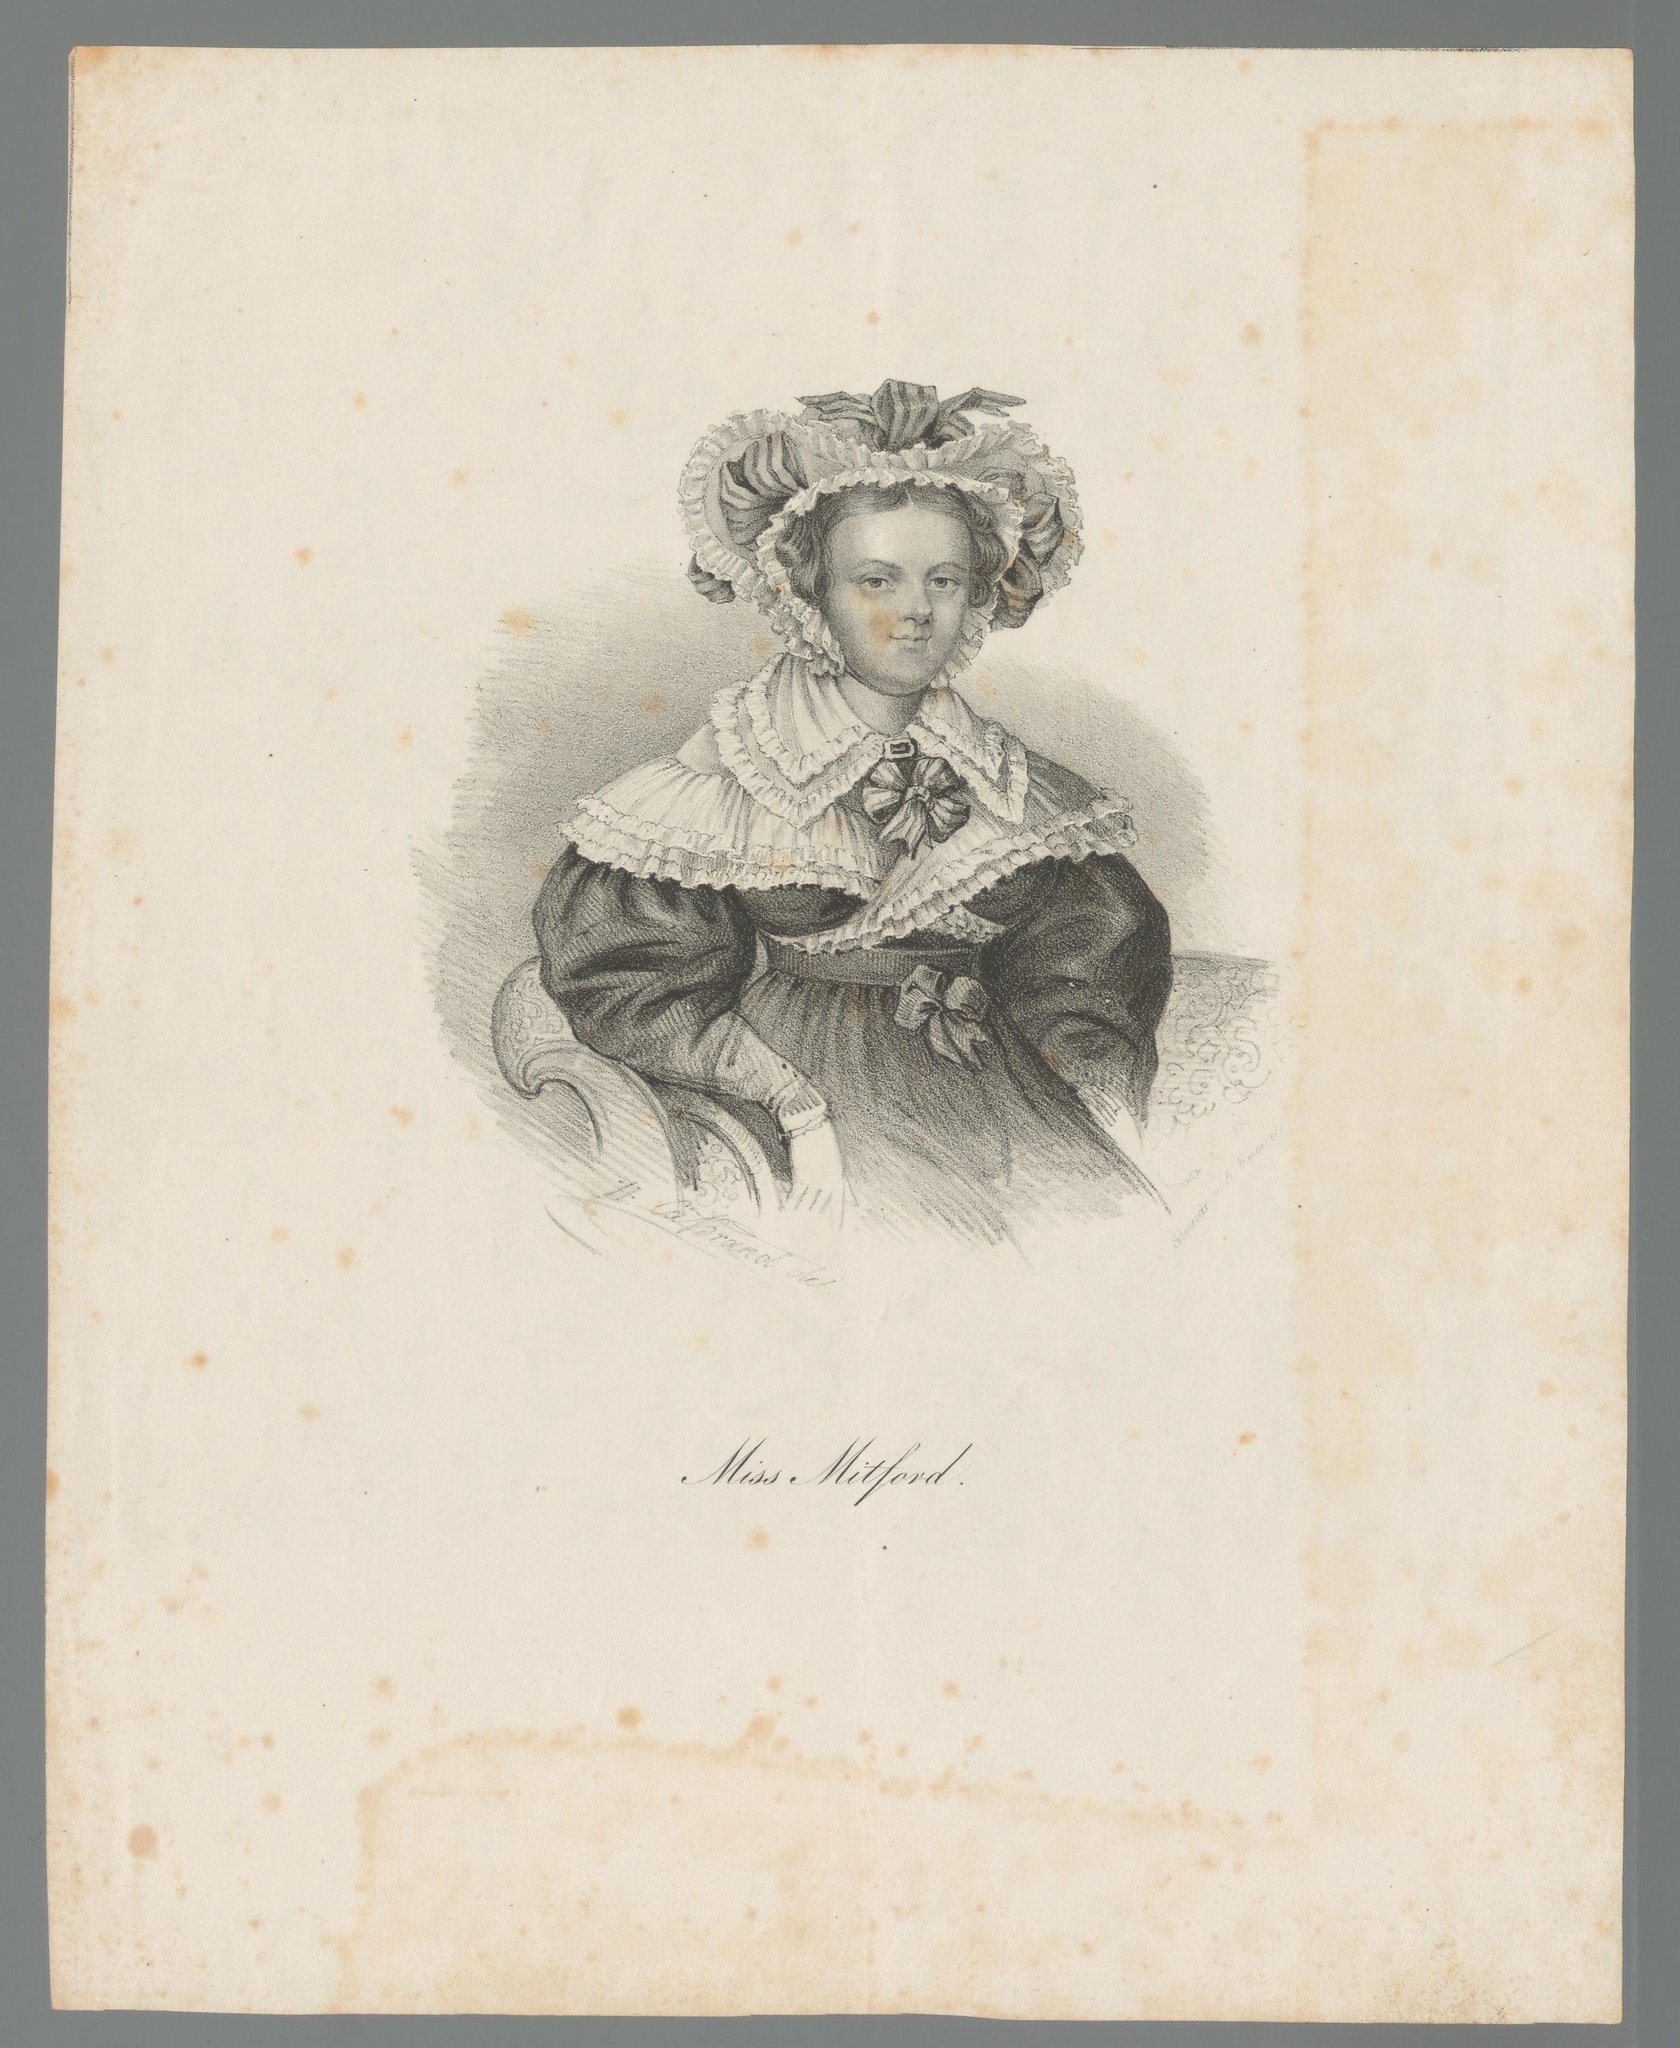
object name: print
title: Miss Mitford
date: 1825-1850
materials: paper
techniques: lithograph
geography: leipzig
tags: adult woman, head-gear, historical persons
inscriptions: collector's mark: Lugt 2228